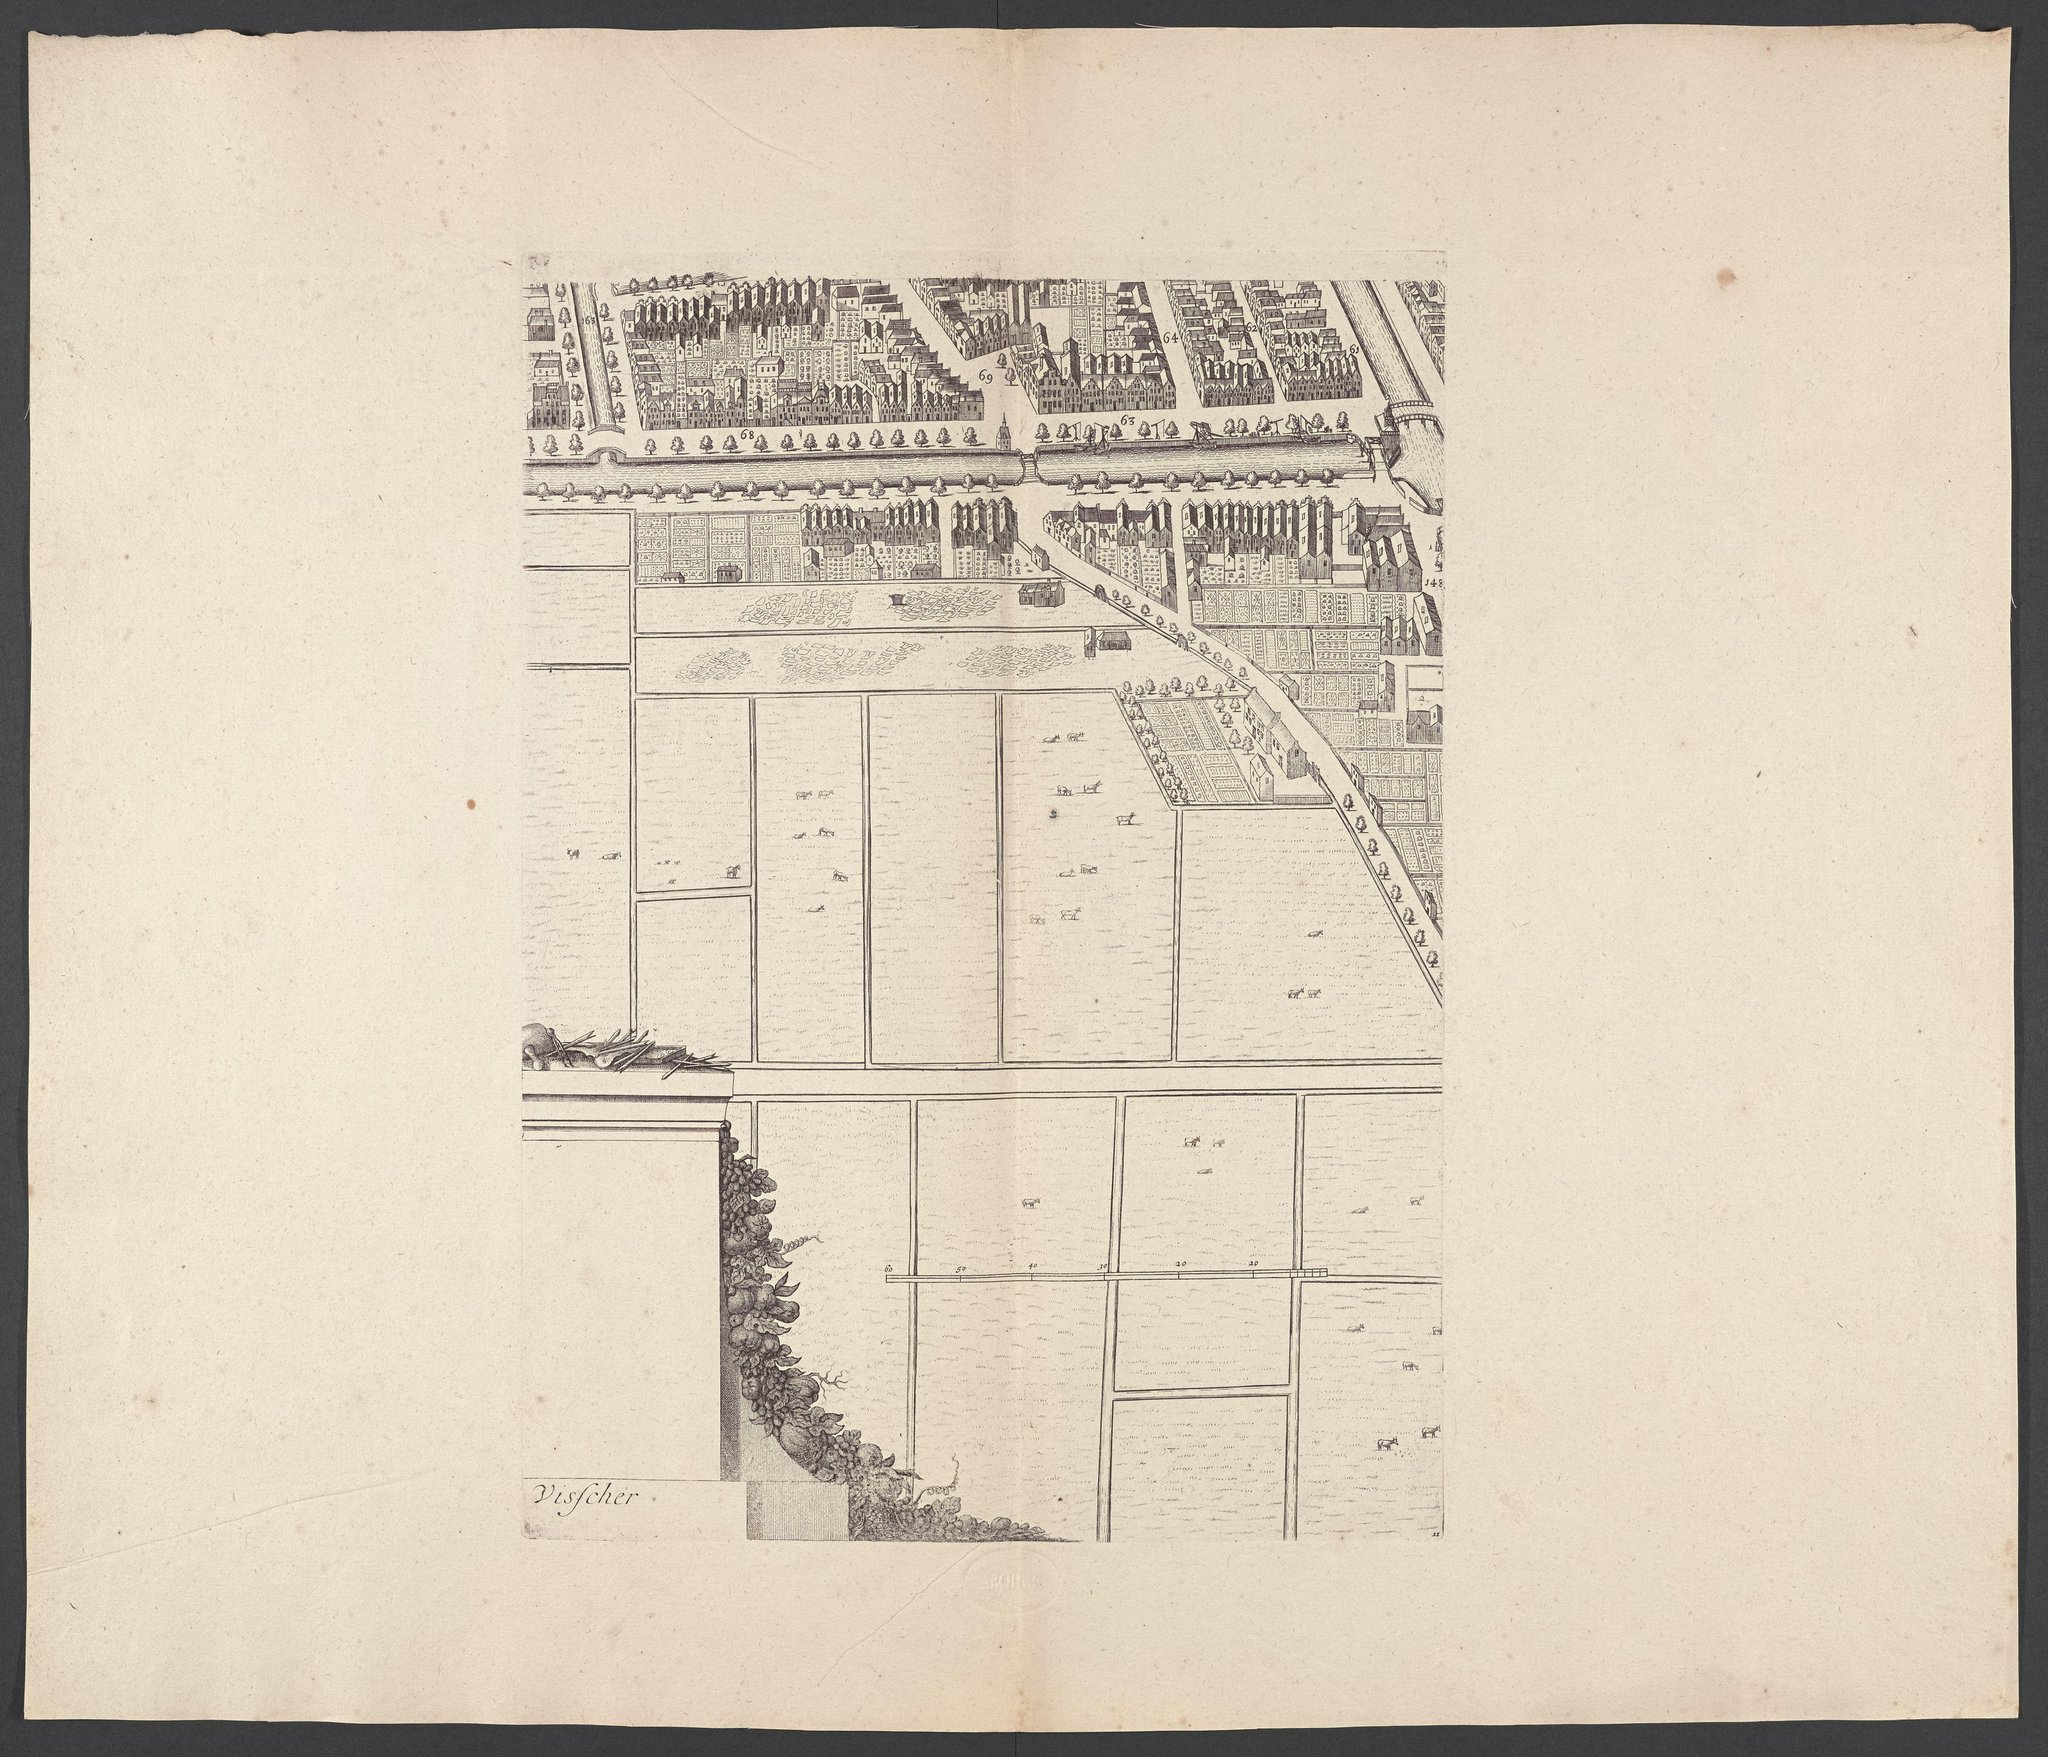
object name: area plan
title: Plattegrond van Den Haag (elfde deel)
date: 1665-1667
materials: paper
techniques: etching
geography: the hague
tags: maps of cities, the hague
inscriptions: collector's mark: Lugt 2228, check stamp: ‘Archief Ministerie van Oorlog Afdeeling Genie’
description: Deze prent is onderdeel van een plattegrond van Den Haag. Deze staat van de plattegrond werd oorspronkelijk uitgegeven met een sierrand, bestaande uit een gezicht op de stad en veertien kleinere gezichten in en om Den Haag, en vormde zo de zogenaamde figuratieve kaart van Den Haag. Voor de prenten die de rand vormen, zie: RP-P-AO-12-8, RP-P-AO-12-8-2, RP-P-OB-50.201, RP-P-OB-50.202, RP-P-OB-50.203, RP-P-OB-50.204, RP-P-OB-50.205, RP-P-OB-50.206, RP-P-OB-50.207, RP-P-OB-50.208, RP-P-OB-102.387, RP-P-OB-50.209, RP-P-OB-50.210, RP-P-OB-50.211, RP-P-OB-50.212, RP-P-OB-50.213, RP-P-AO-12-5-4 en RP-P-OB-50.214.